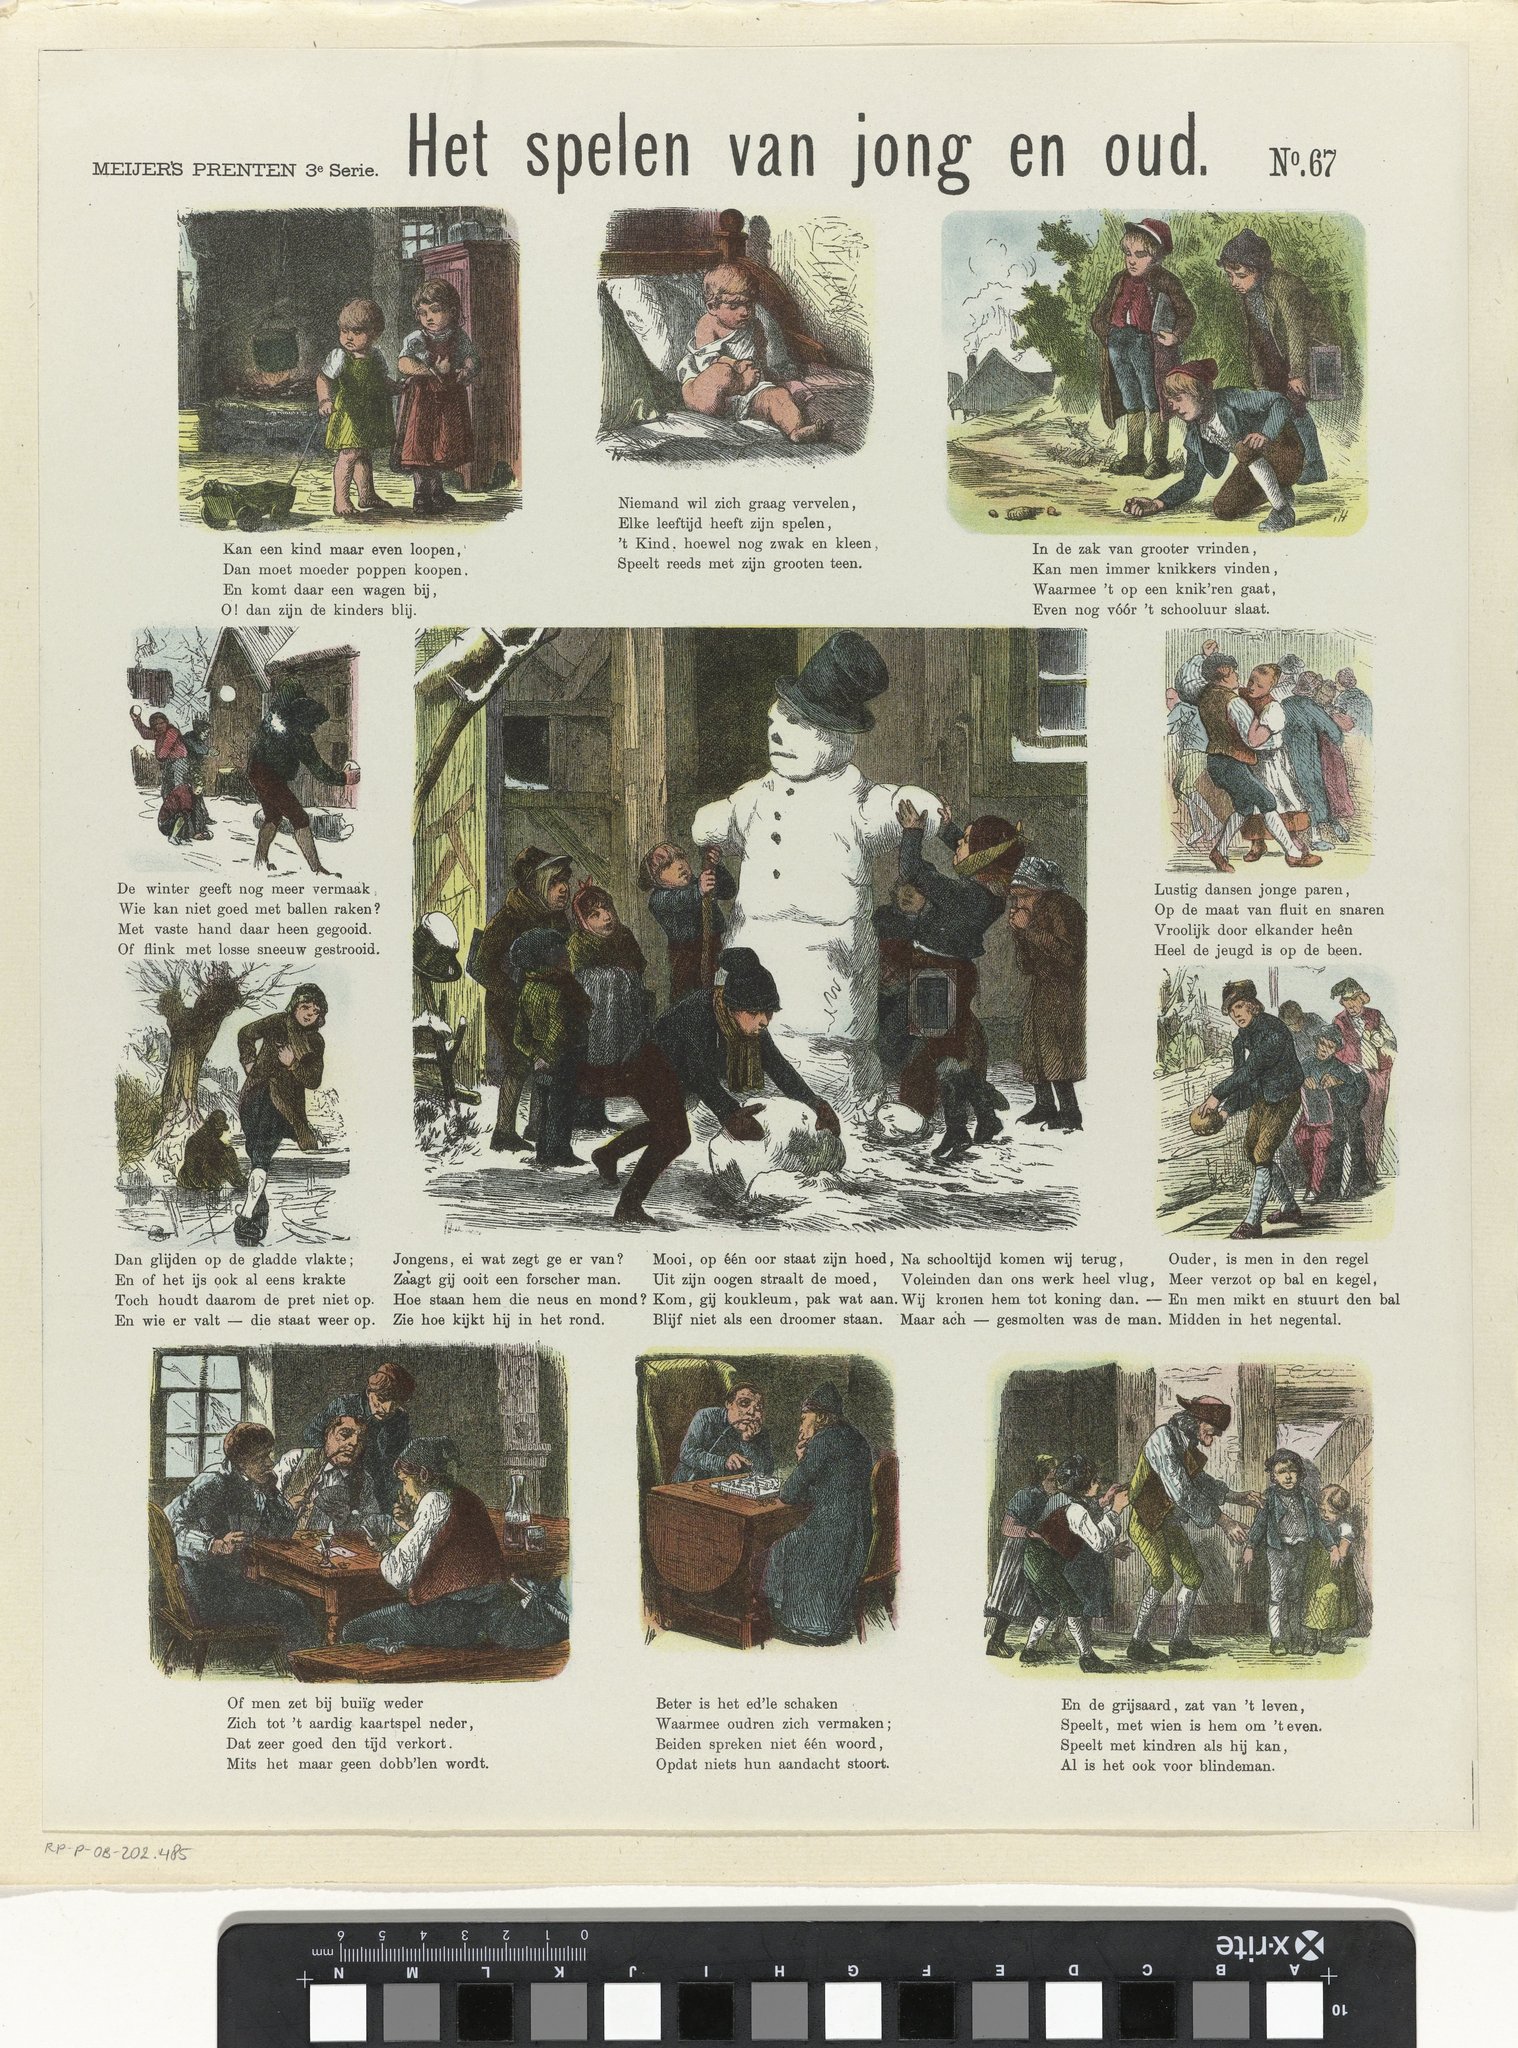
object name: print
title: Het spelen van jong en oud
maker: Anonymous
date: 1878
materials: paper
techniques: lithograph, letterpress printing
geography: amsterdam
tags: children's games and plays, blind-man's buff, (making a) snowman, throwing snowballs, games using special objects (marbles, top, hoop, etc.)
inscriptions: collector's mark: Lugt 2760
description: Blad met 11 voorstellingen van kinderspelen en bezigheden, waaronder spelen met de pop, verveling, knikkeren, sneeuwballen gooien, sneeuwpop maken, dansen, schaatsen, kegelen, kaartspelen, schaken en blindemannetje spelen. Onder elke voorstelling een vers. Genummerd rechtsboven: No. 67.